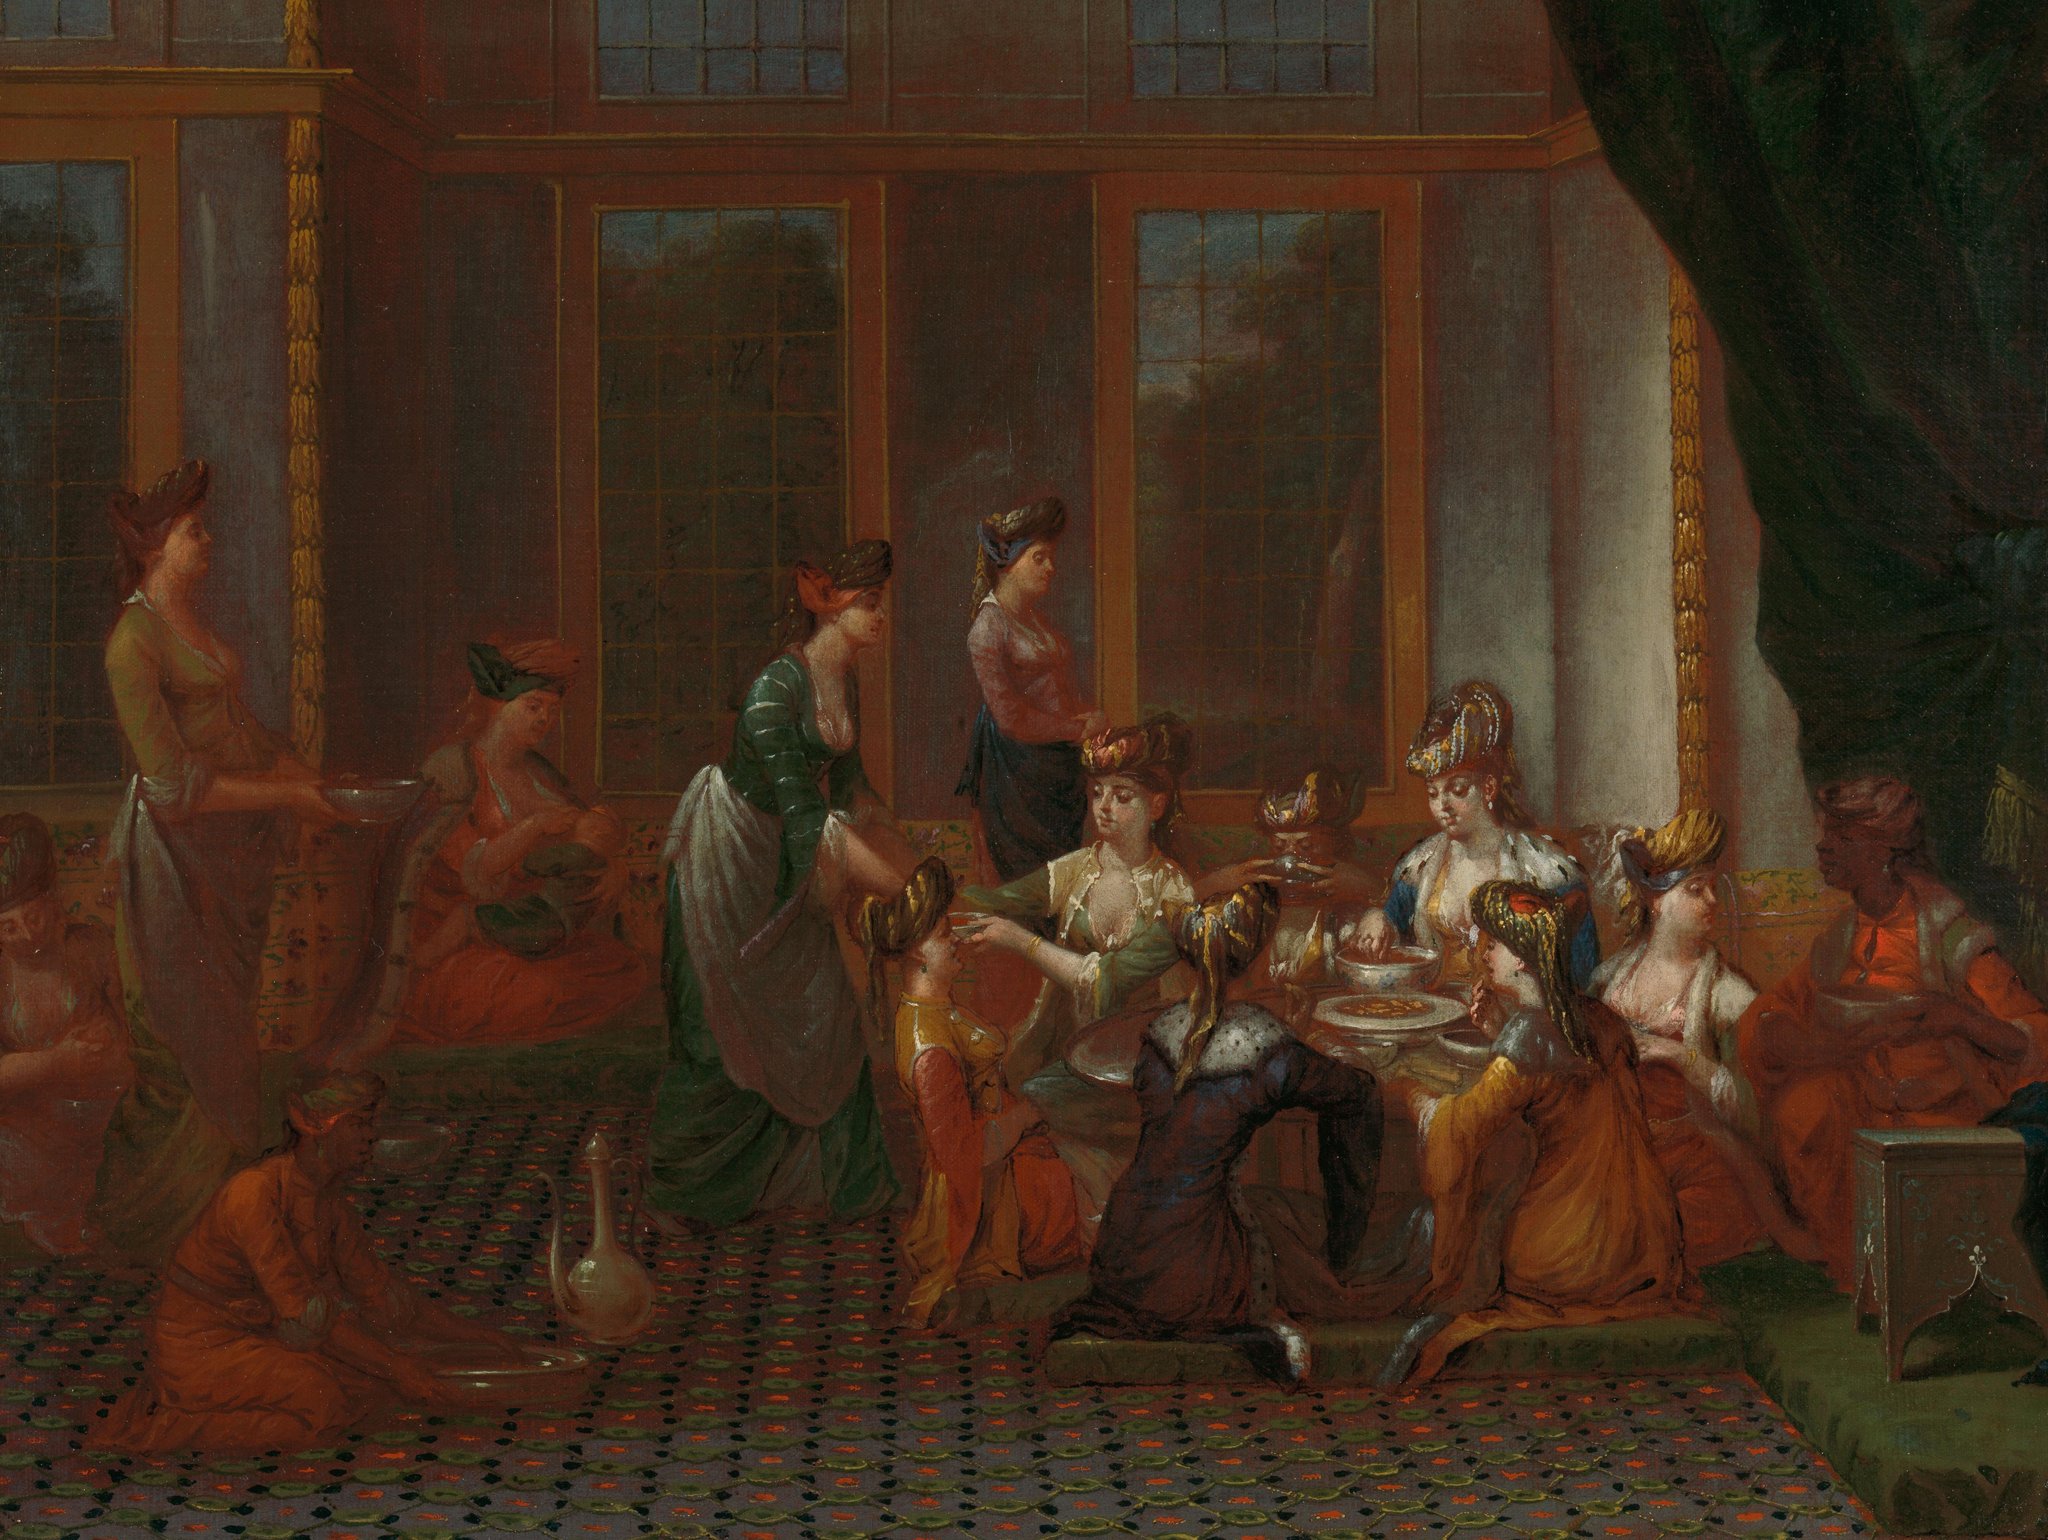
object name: painting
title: Banquet of Distinguished Turkish Women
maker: jean baptiste vanmour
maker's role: painter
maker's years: 1671-1737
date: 1720-1737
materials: canvas, oil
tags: slavery; serfs and enslaved persons, waiting at table, evening meal, dinner, supper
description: Here we see a group of women surrounded by enslaved female servants and on the sofa near the window a woman nursing her child. Affluent Turkish women visited one another frequently. The guests also often spent the night. It was said that a well-connected woman never had to stay at home, but could be out visiting all the time.